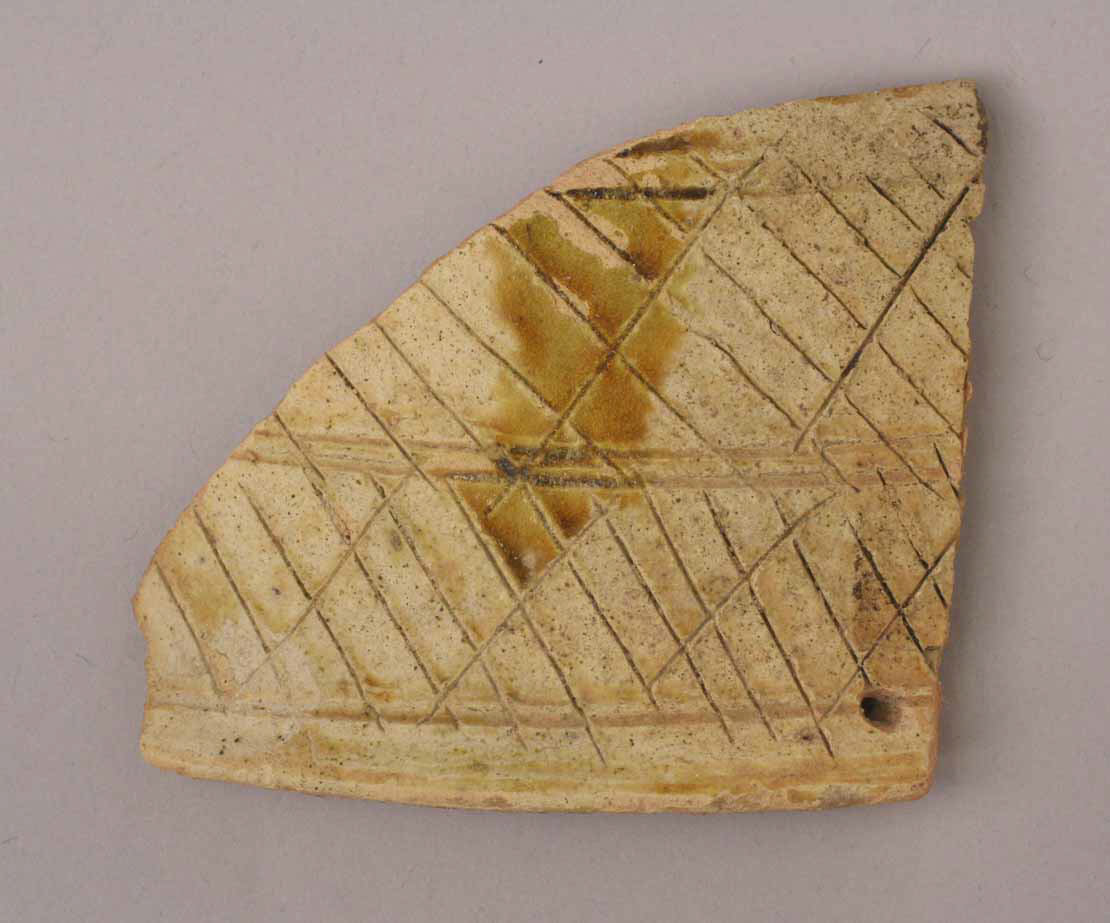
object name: fragment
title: Ceramic Fragment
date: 1001-1100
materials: earthenware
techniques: incising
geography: saudi arabia